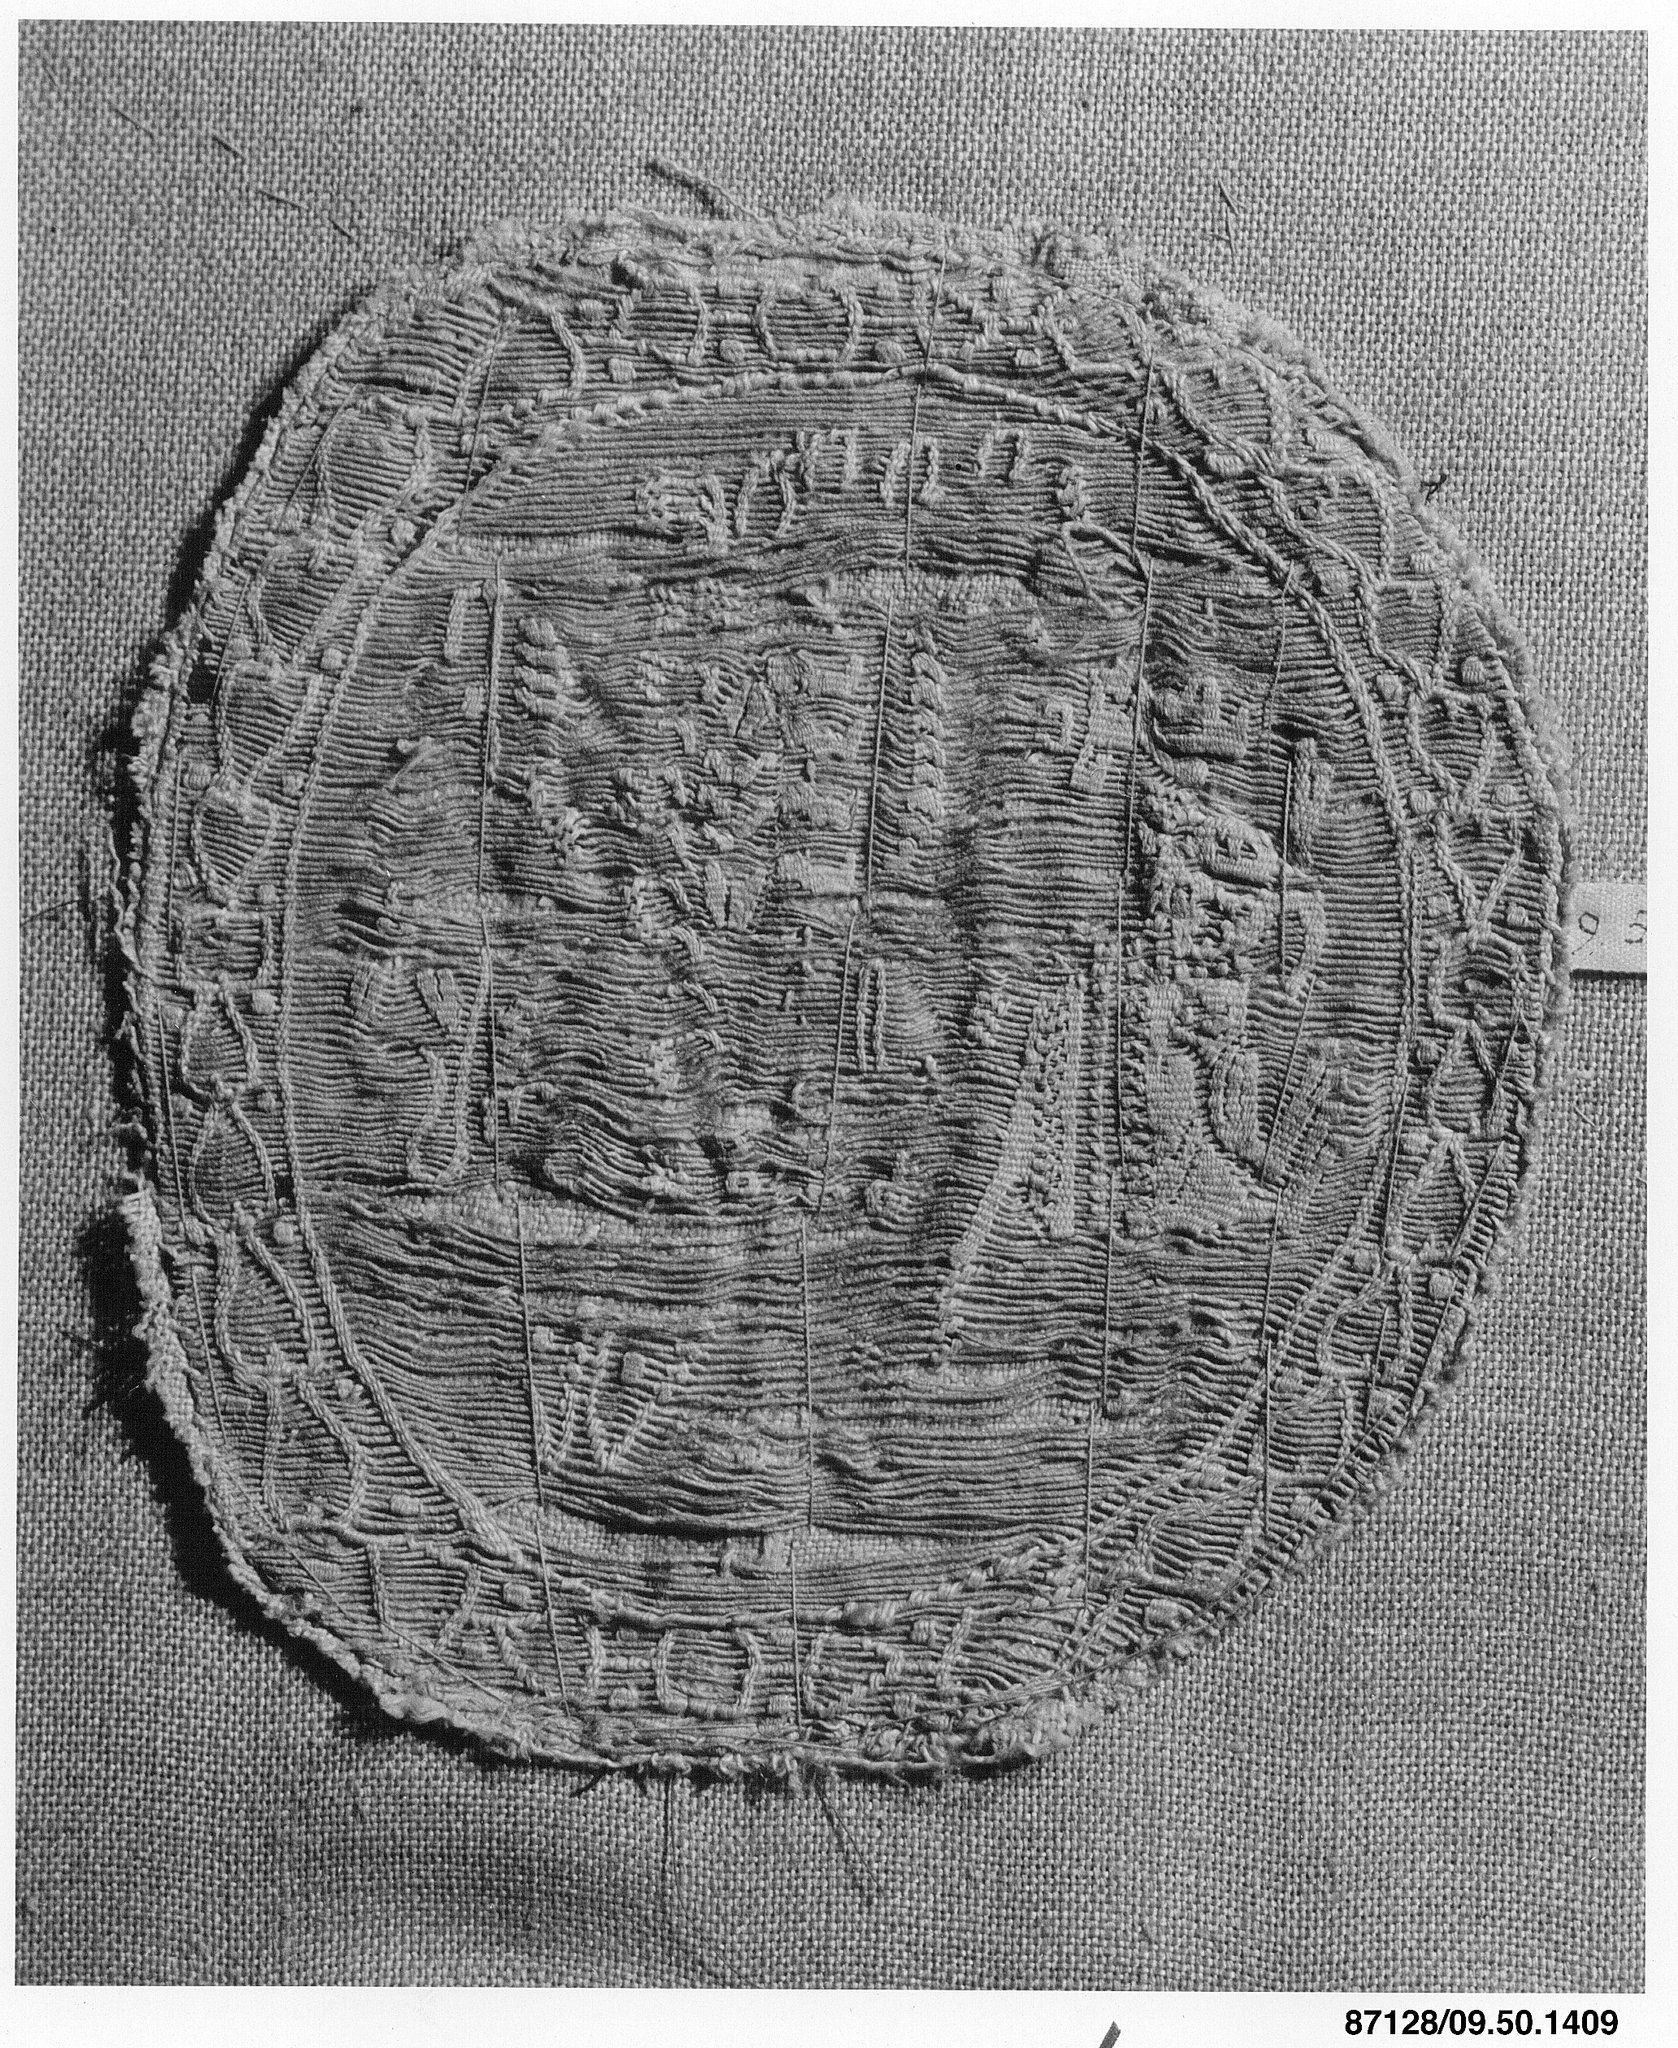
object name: roundel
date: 401-700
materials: linen, wool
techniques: weave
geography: egypt